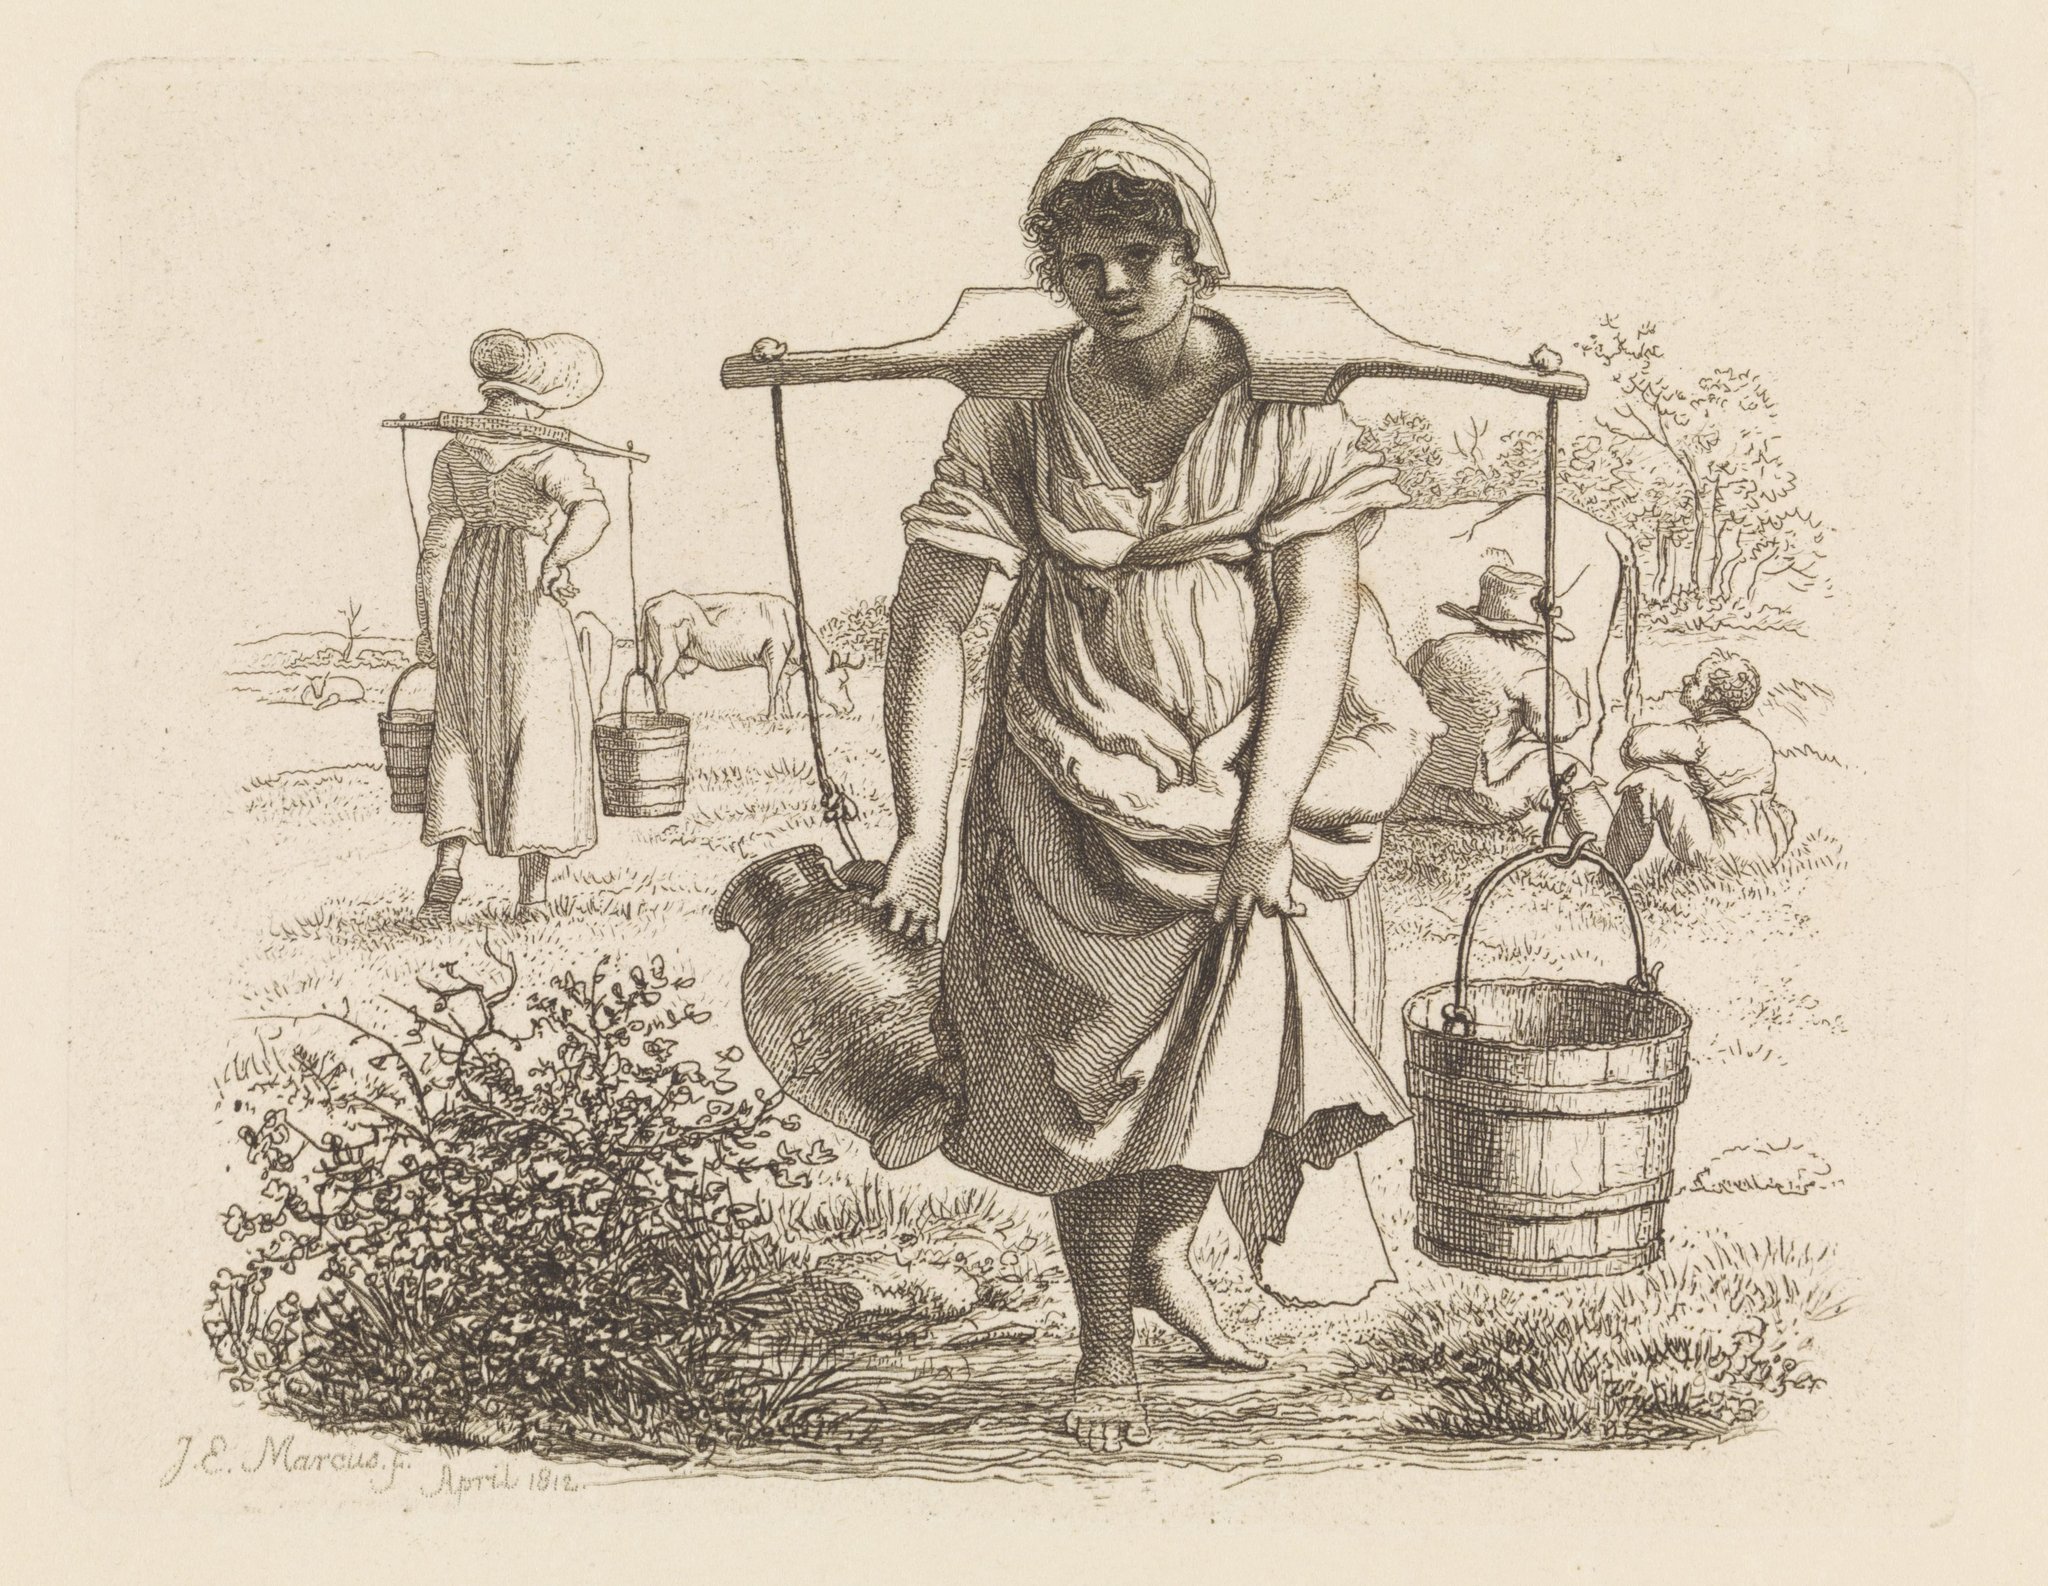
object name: print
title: Twee melkmeisjes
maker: jacob ernst marcus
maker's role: draughtsman, print maker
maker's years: 1774-1826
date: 1804-1812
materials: paper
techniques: etching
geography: amsterdam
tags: cow, carrying something with yoke, container of ceramics: jar, jug, pot, vase, milkmaid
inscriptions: collector's mark: Lugt 2228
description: Serie voor het eerst uitgegeven door Jacob Ernst Marcus onder de titel Studiebeelden en Fragmenten. Amsterdam: ca.1816. Later heruitgegeven als: Studie-prentwerk/ Etudes gravées.